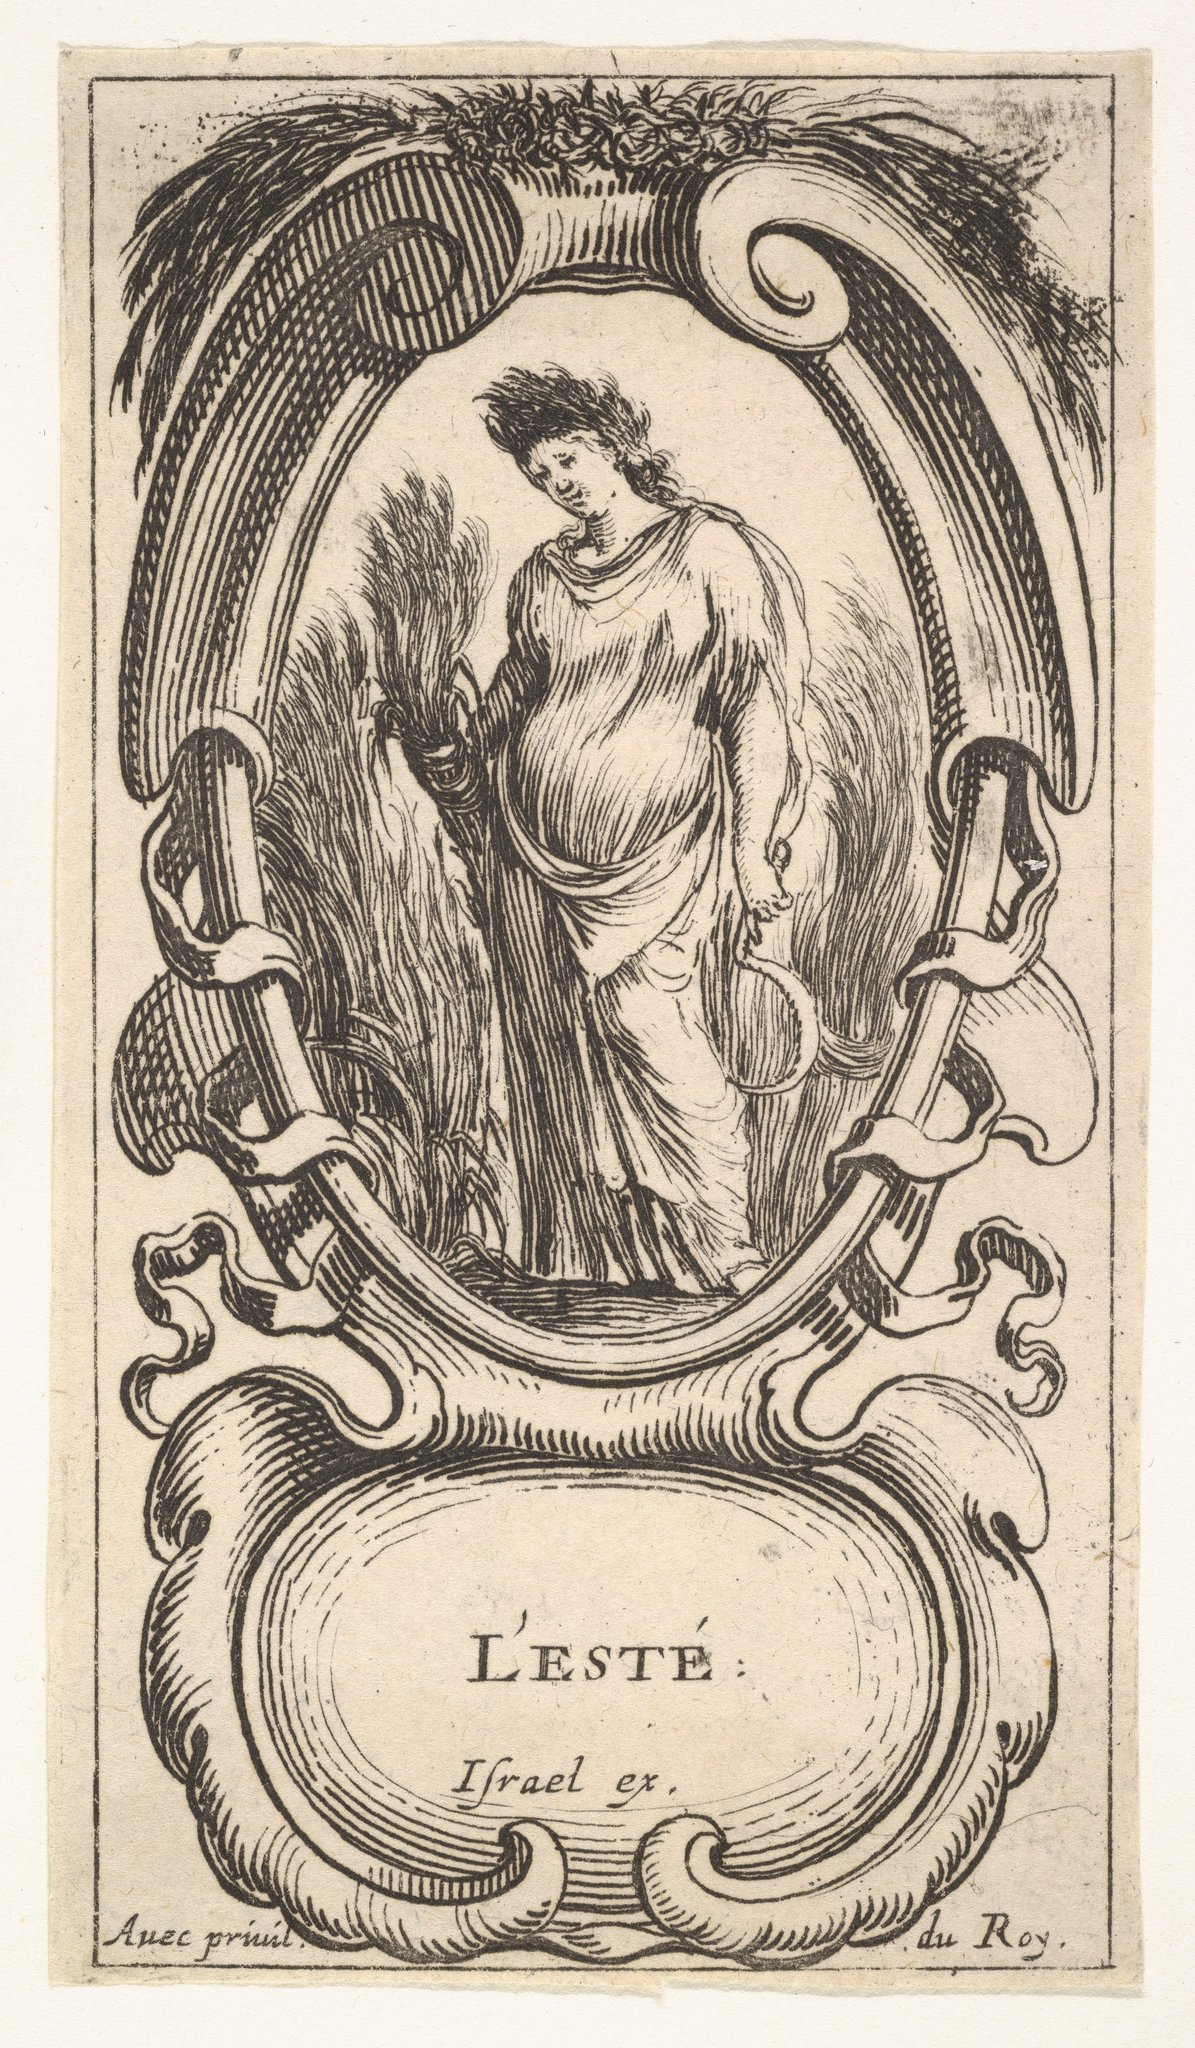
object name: print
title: Summer, a woman, crowned with corn, standing in a cornfield with corn in her right hand and a scythe in her left hand, within a cartouche topped with corn, from "The Four Seasons" (Les Quatre Saisons)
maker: stefano della bella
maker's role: artist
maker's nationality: italian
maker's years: 1610-1664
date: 1638-1643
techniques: etching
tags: women